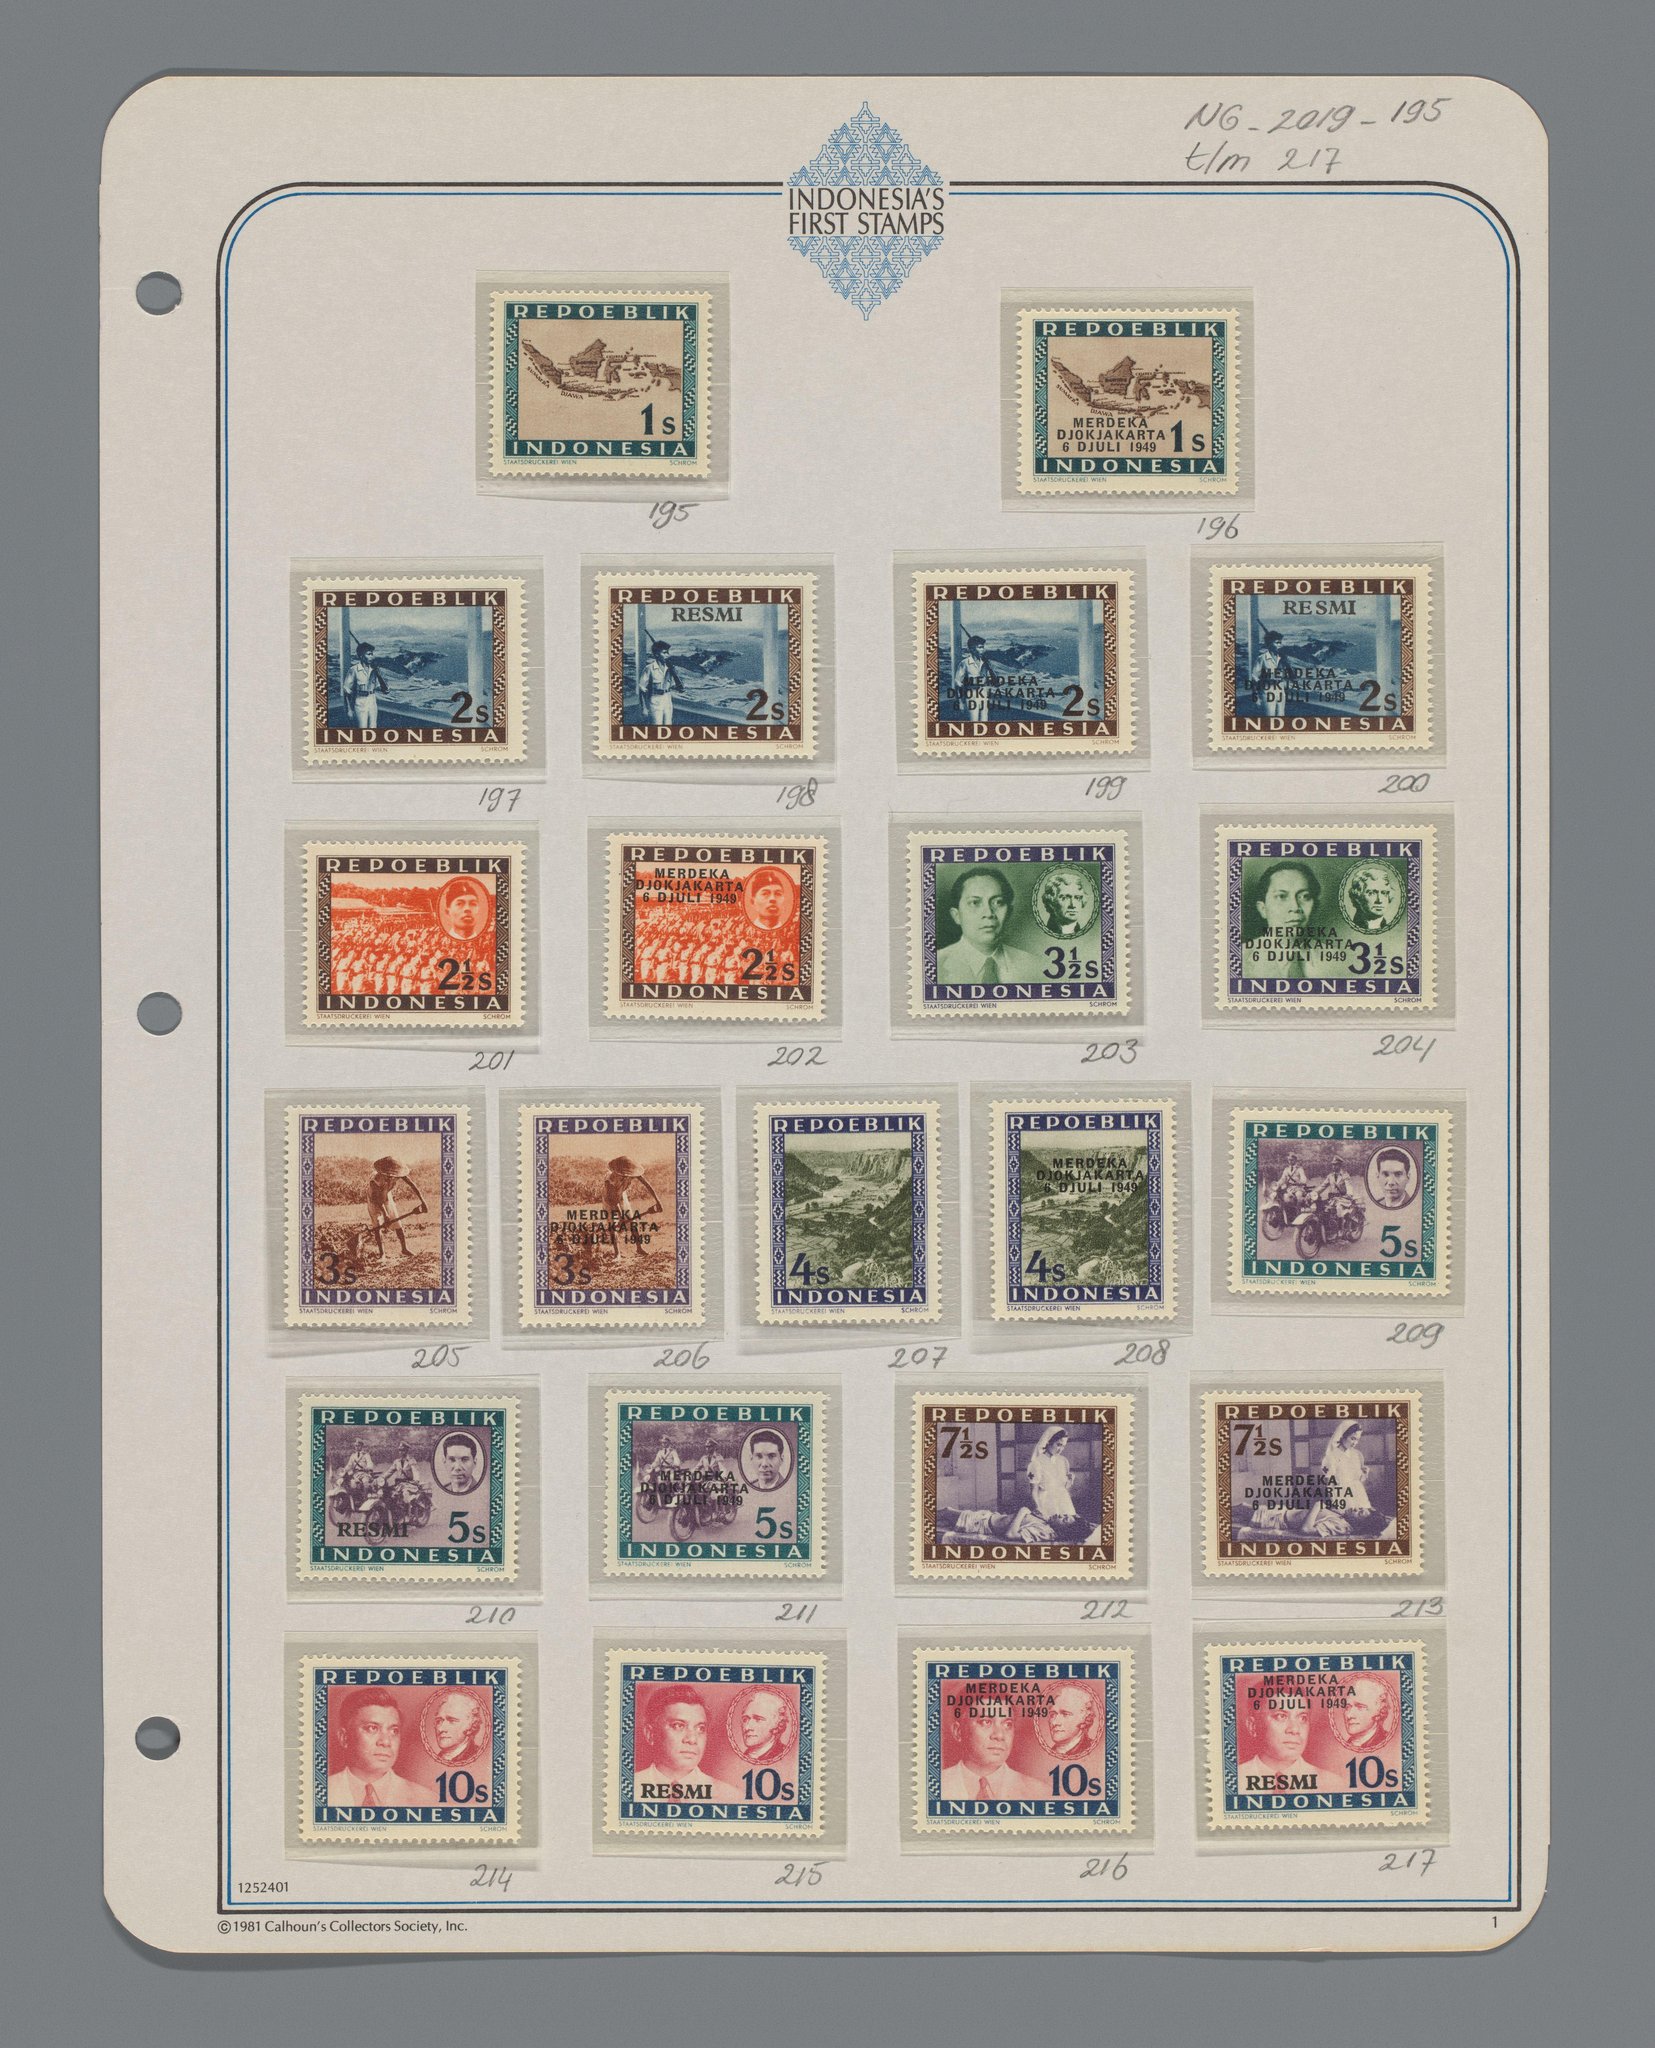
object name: postage stamp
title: Postzegel Republik Indonesia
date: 1949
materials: paper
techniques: photoaquatint, engraving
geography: vienna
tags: indonesia